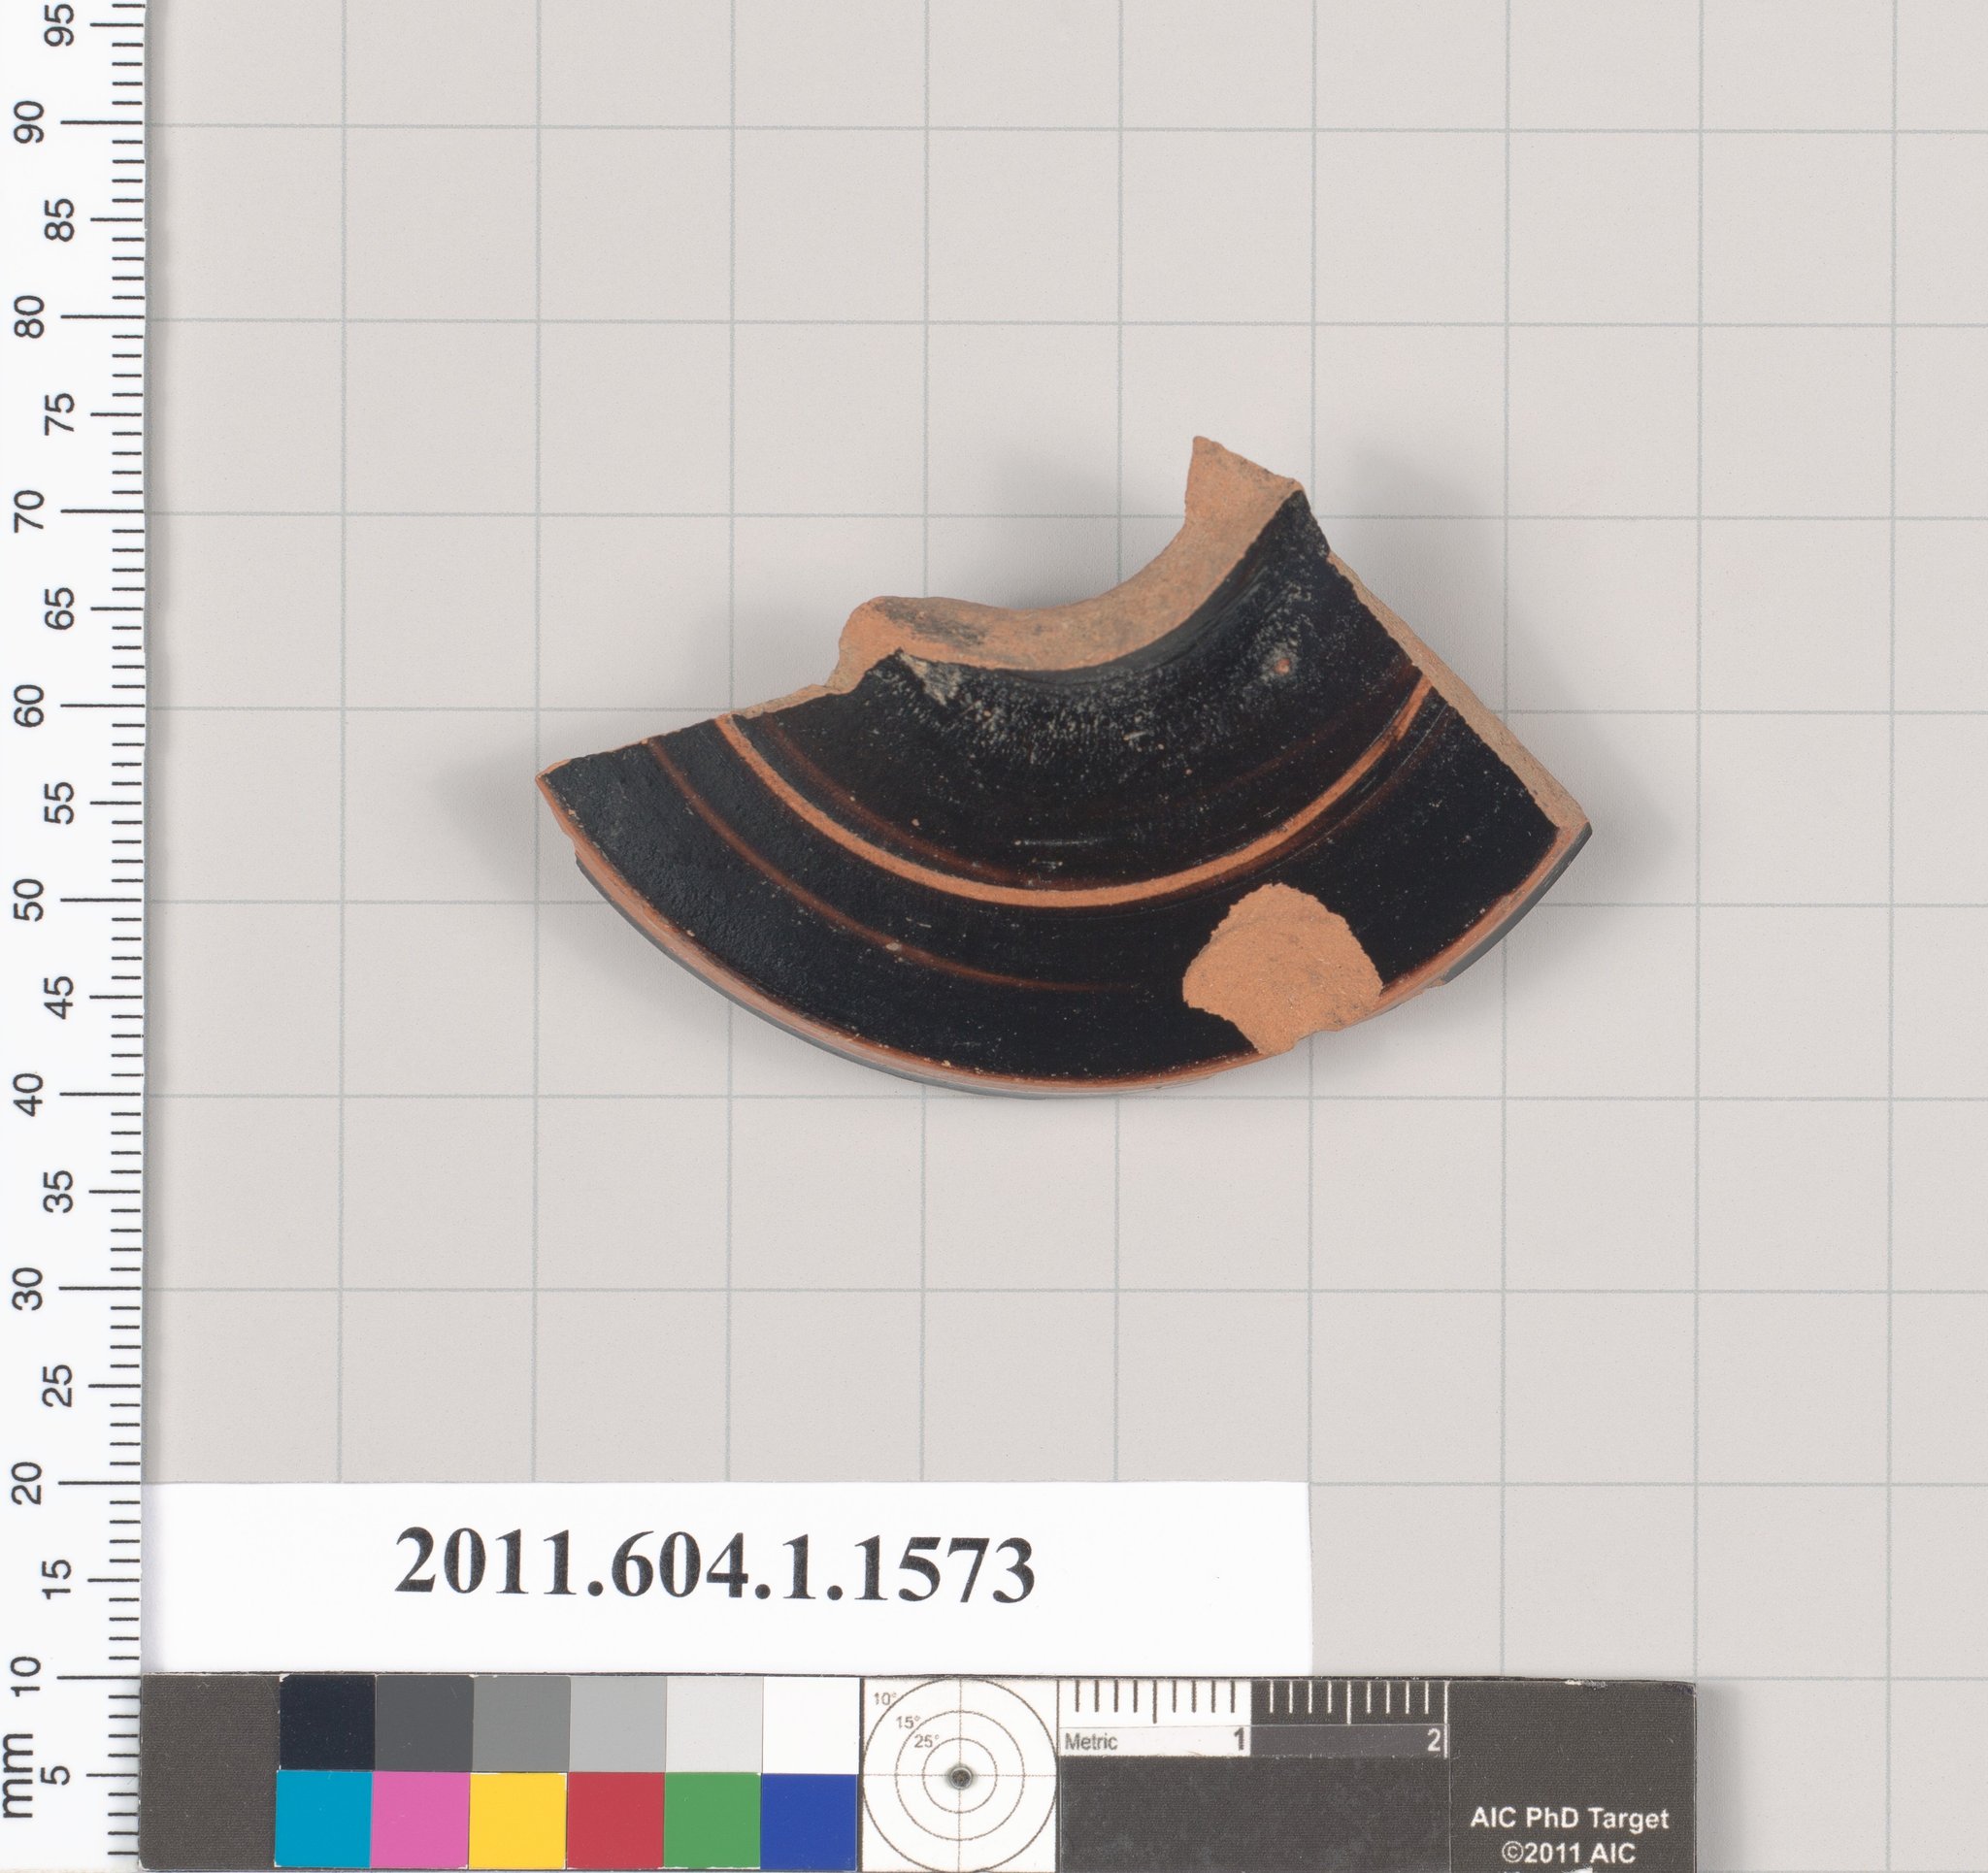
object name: kylix fragment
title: Terracotta fragment of a kylix (drinking cup)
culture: greek, attic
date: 500-401 BCE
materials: terracotta